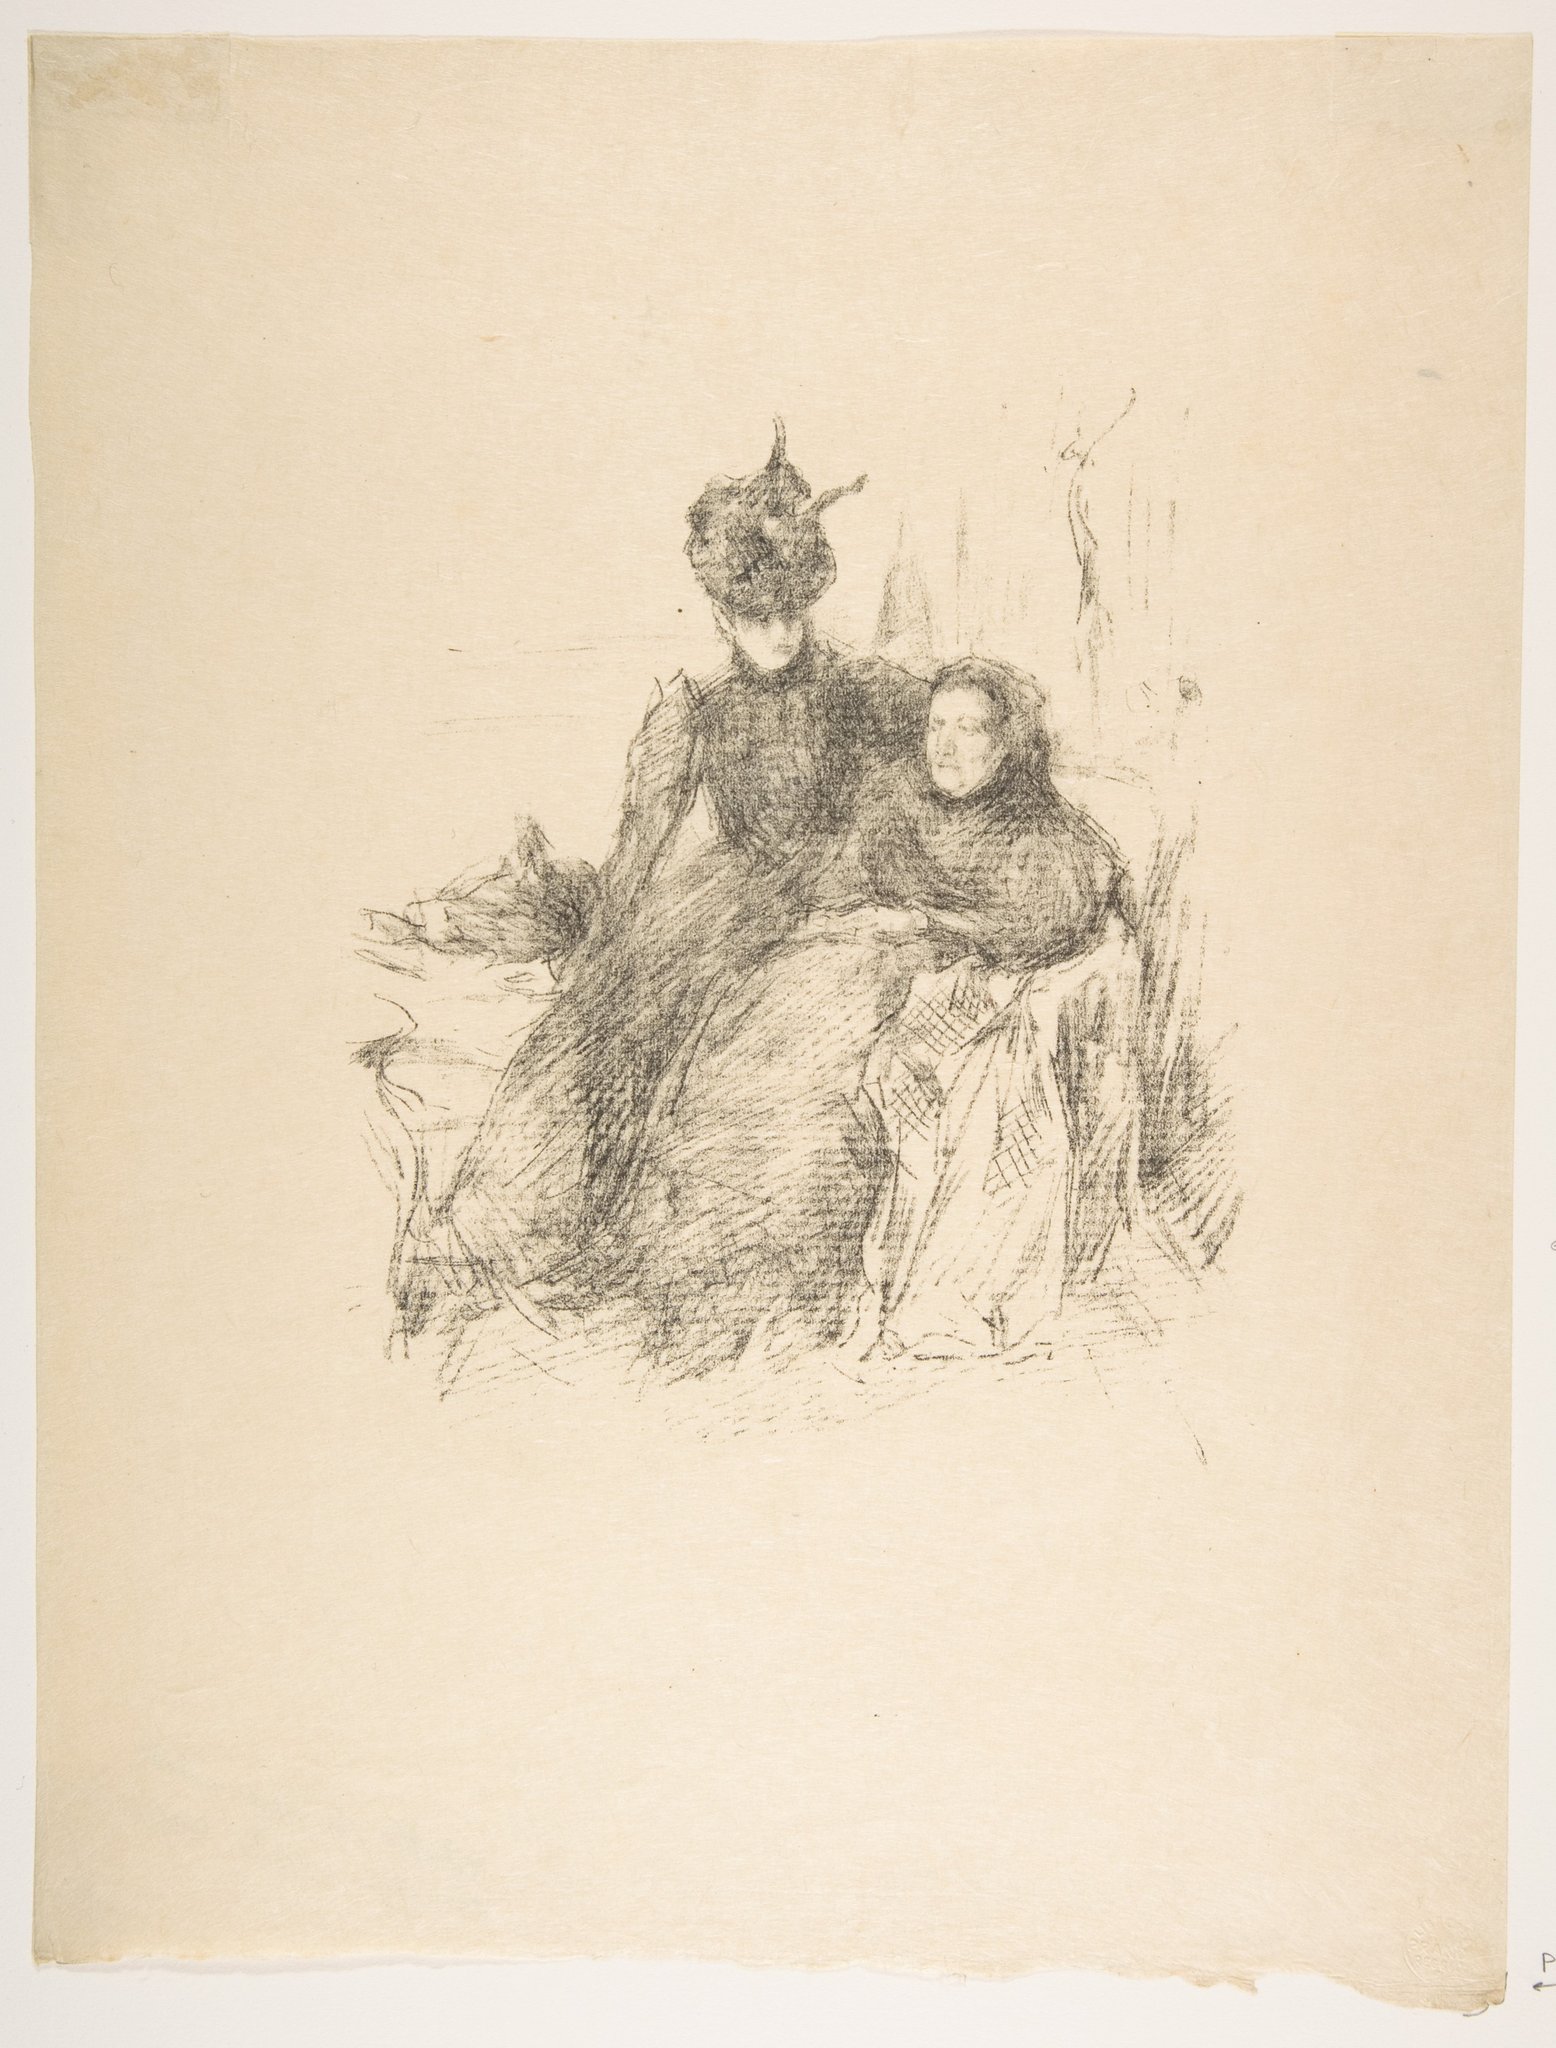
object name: print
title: Mother and Daughter (La Mère Malade)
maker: james mcneill whistler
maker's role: artist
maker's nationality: american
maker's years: 1834-1903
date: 1897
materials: ink, paper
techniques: printing, stumping, lithography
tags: mothers,women